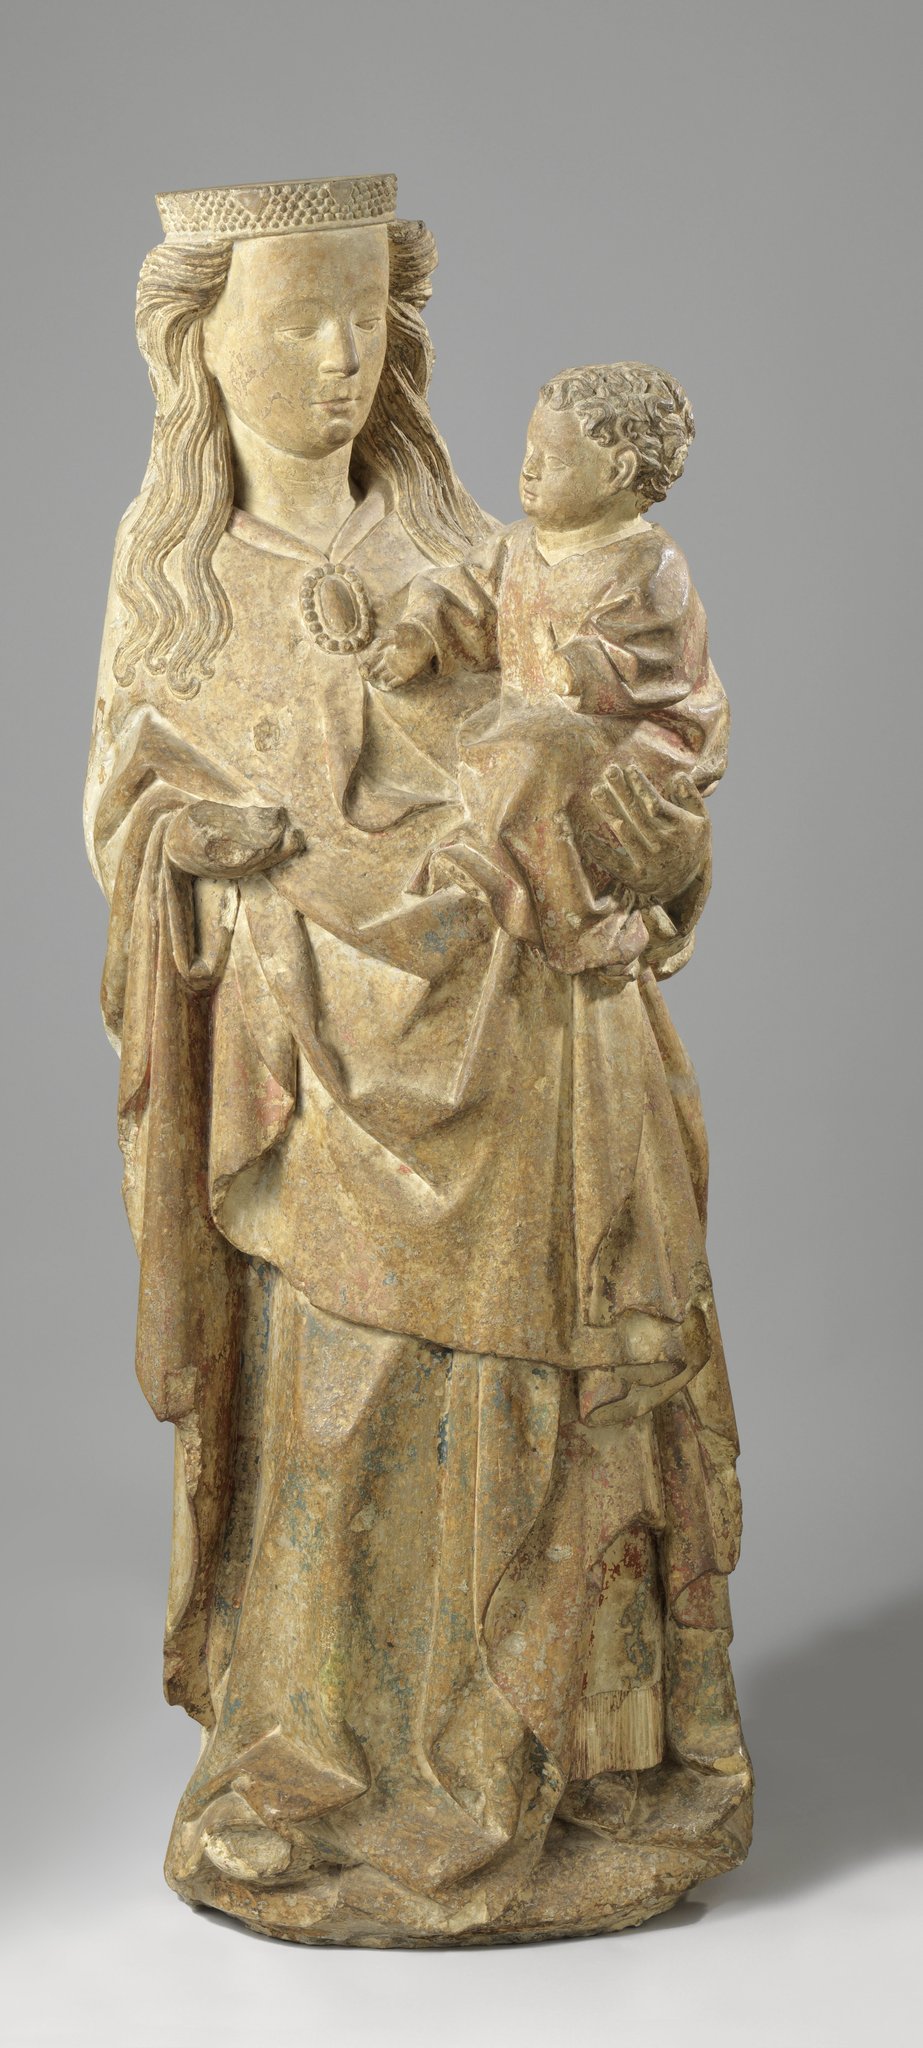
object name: figure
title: Maria met kind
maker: Anonymous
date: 1480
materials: limestone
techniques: polychromy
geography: troyes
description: Maria en Christus. Kalksteen met sporen van polychromie. Troyes, ca. 1460.